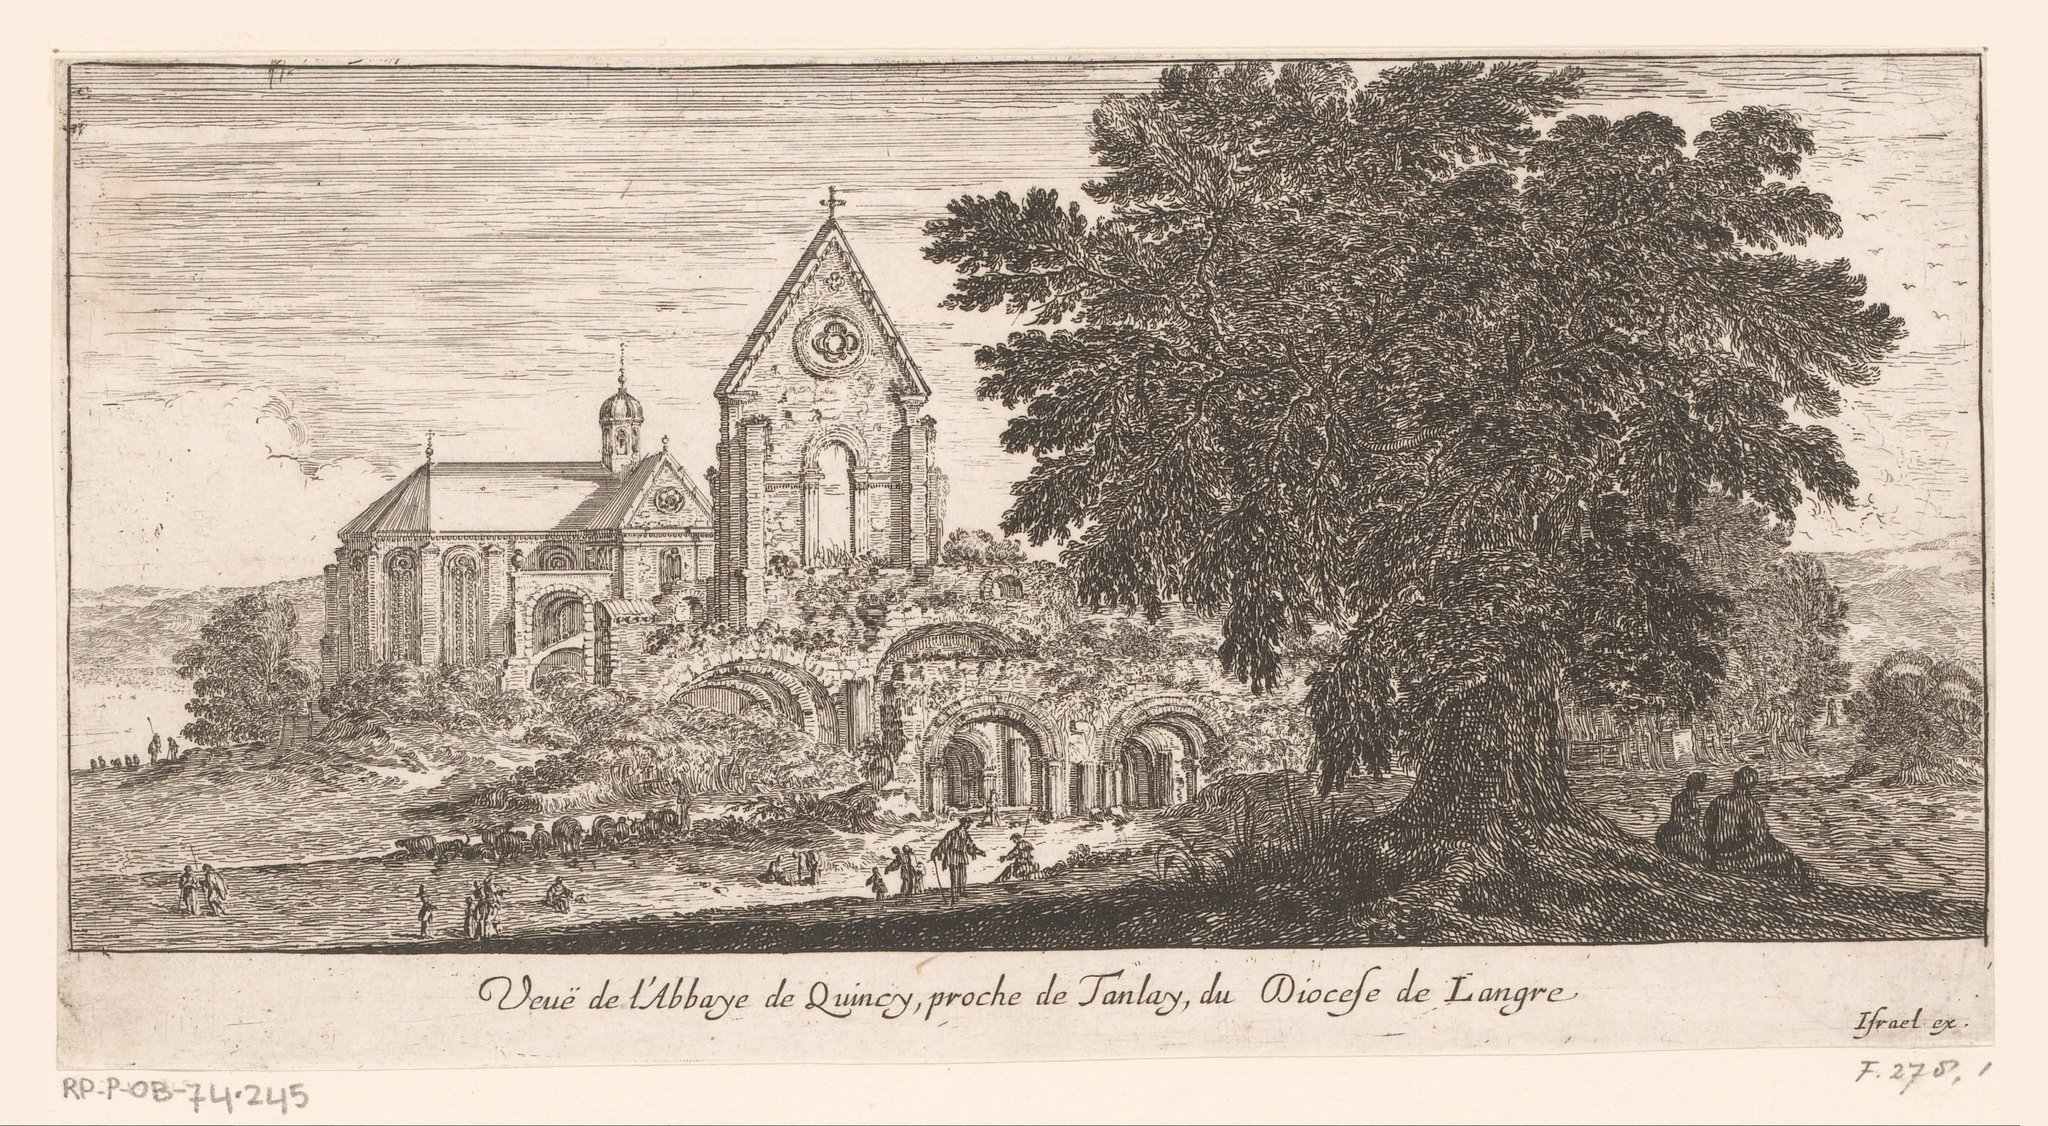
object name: print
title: Gezicht op de abdij van Quincy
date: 1631-1691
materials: paper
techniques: engraving, etching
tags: city-view, and landscape with man-made constructions, abbey, monastery, convent ~ roman catholic church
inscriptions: collector's mark: Lugt 240